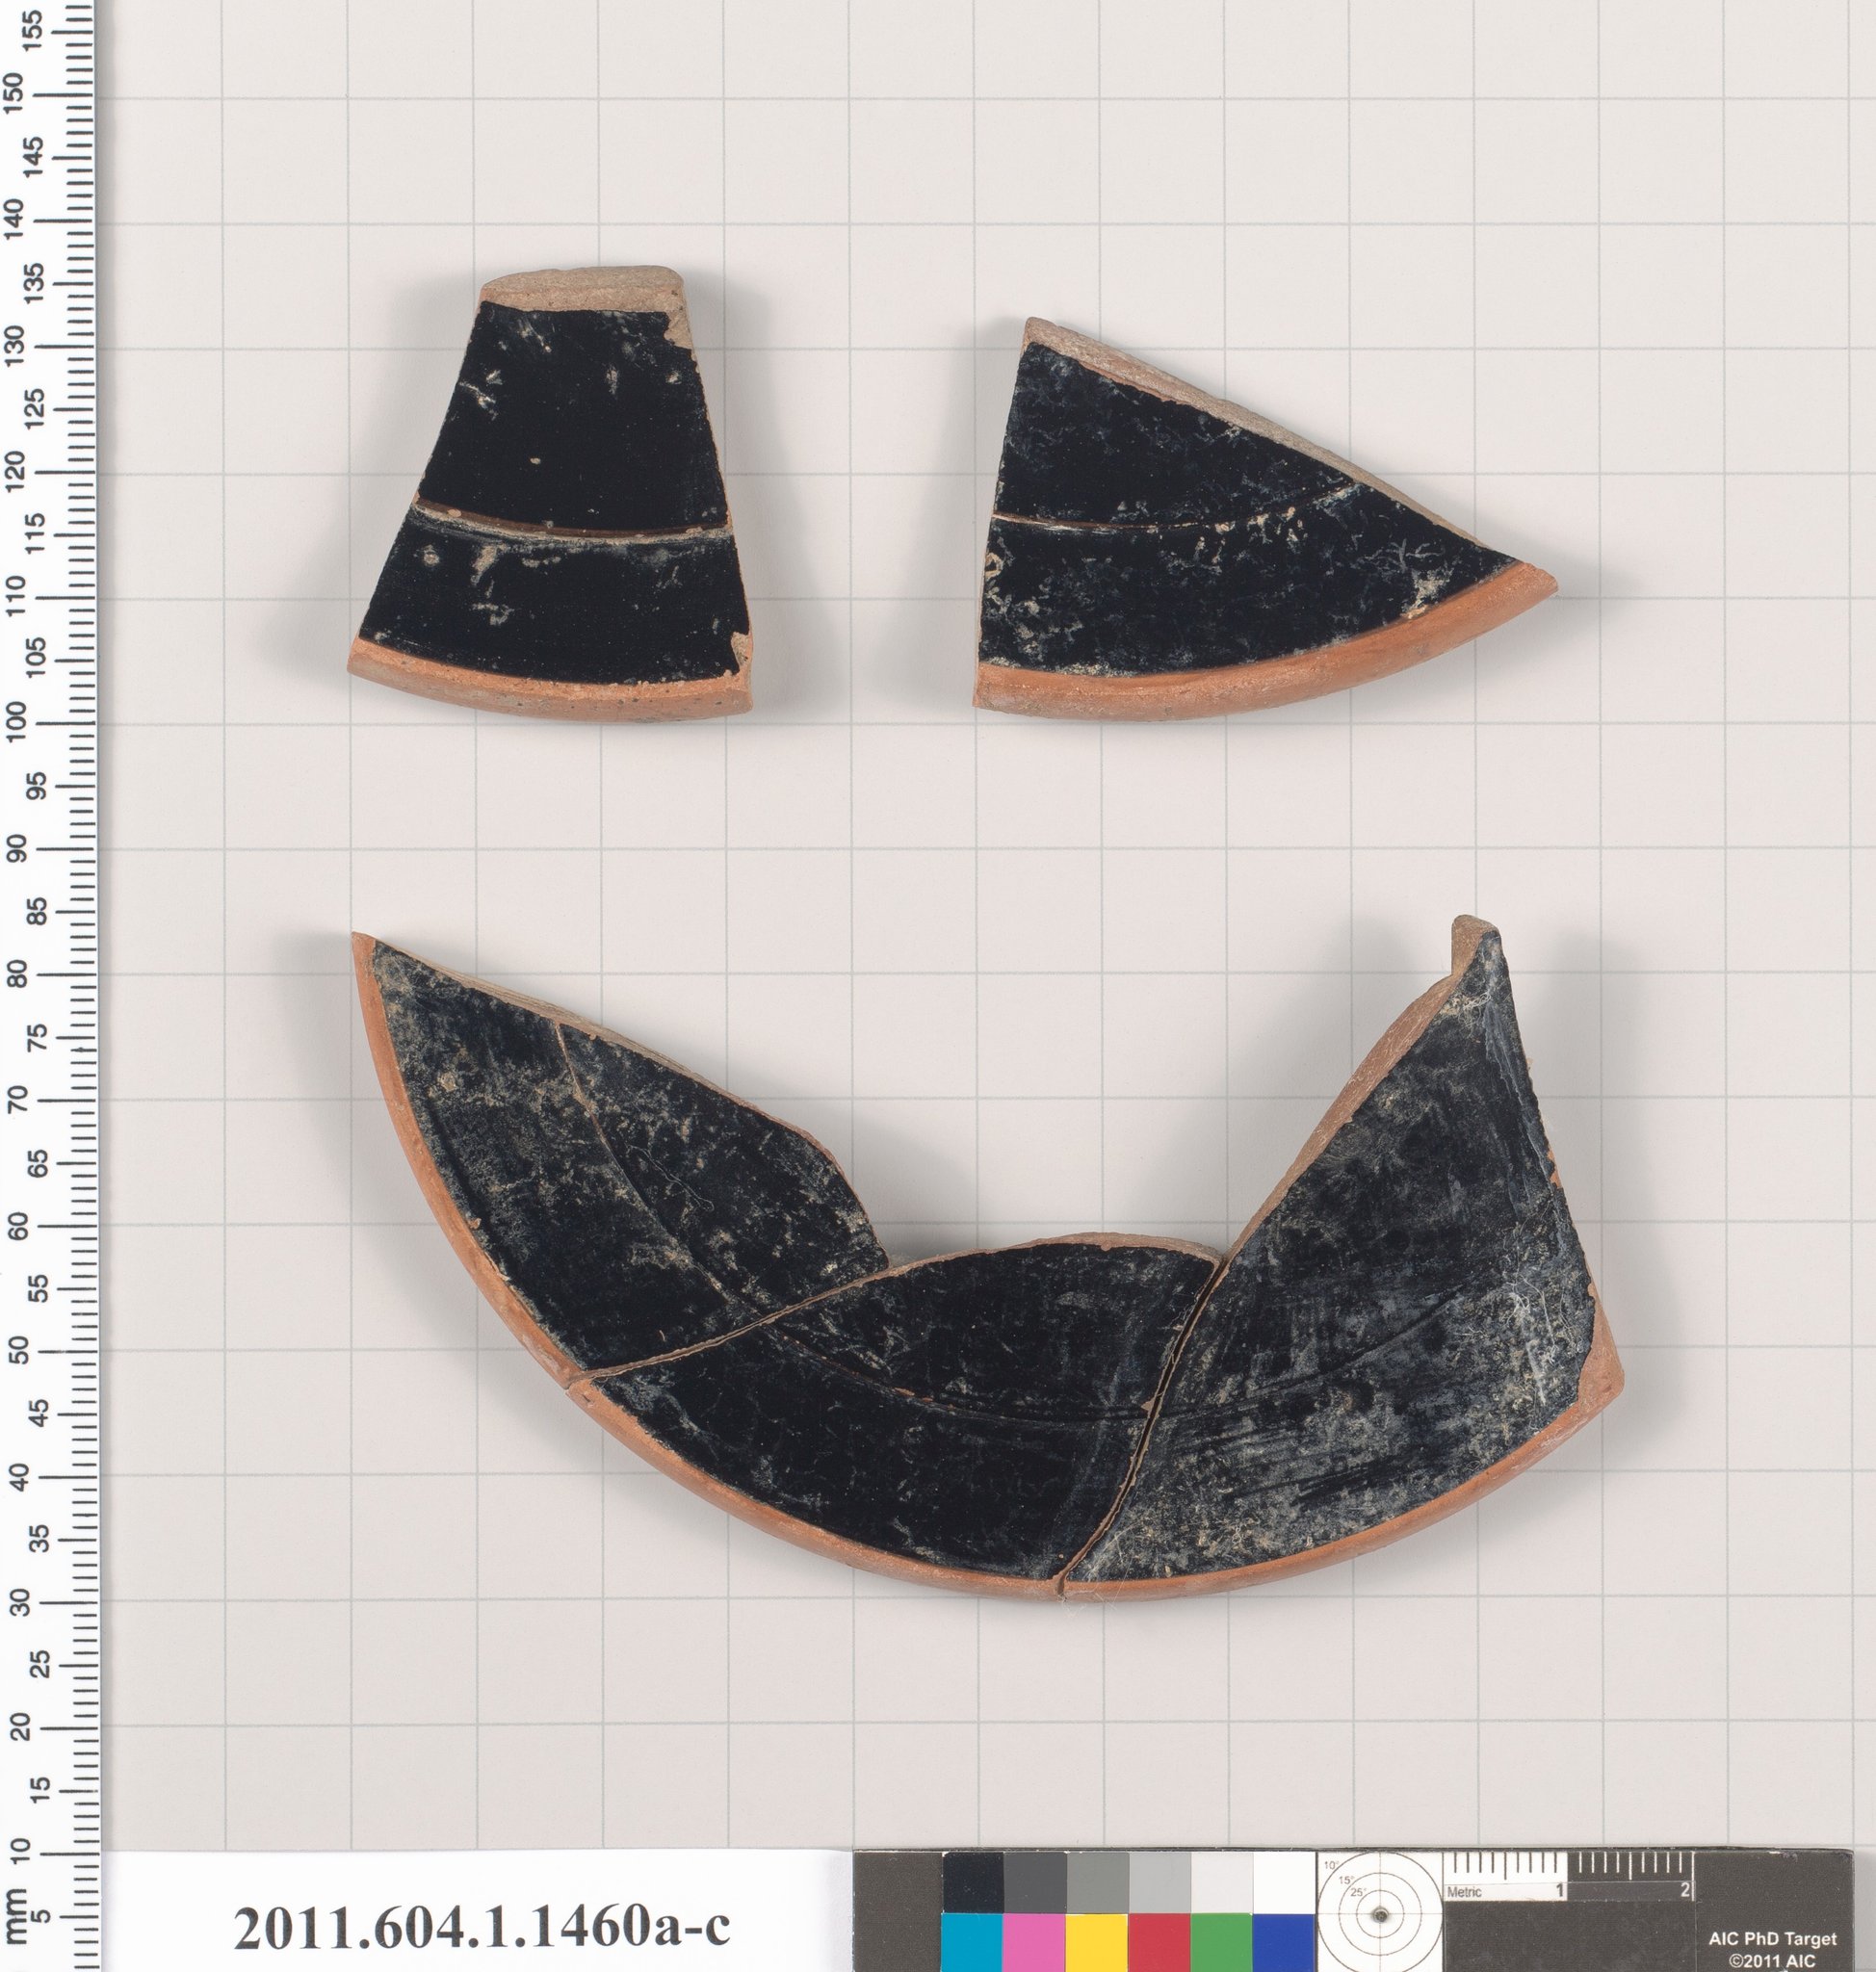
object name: kylix fragment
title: Terracotta fragments of kylikes (drinking cups)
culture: greek, attic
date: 500-401 BCE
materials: terracotta